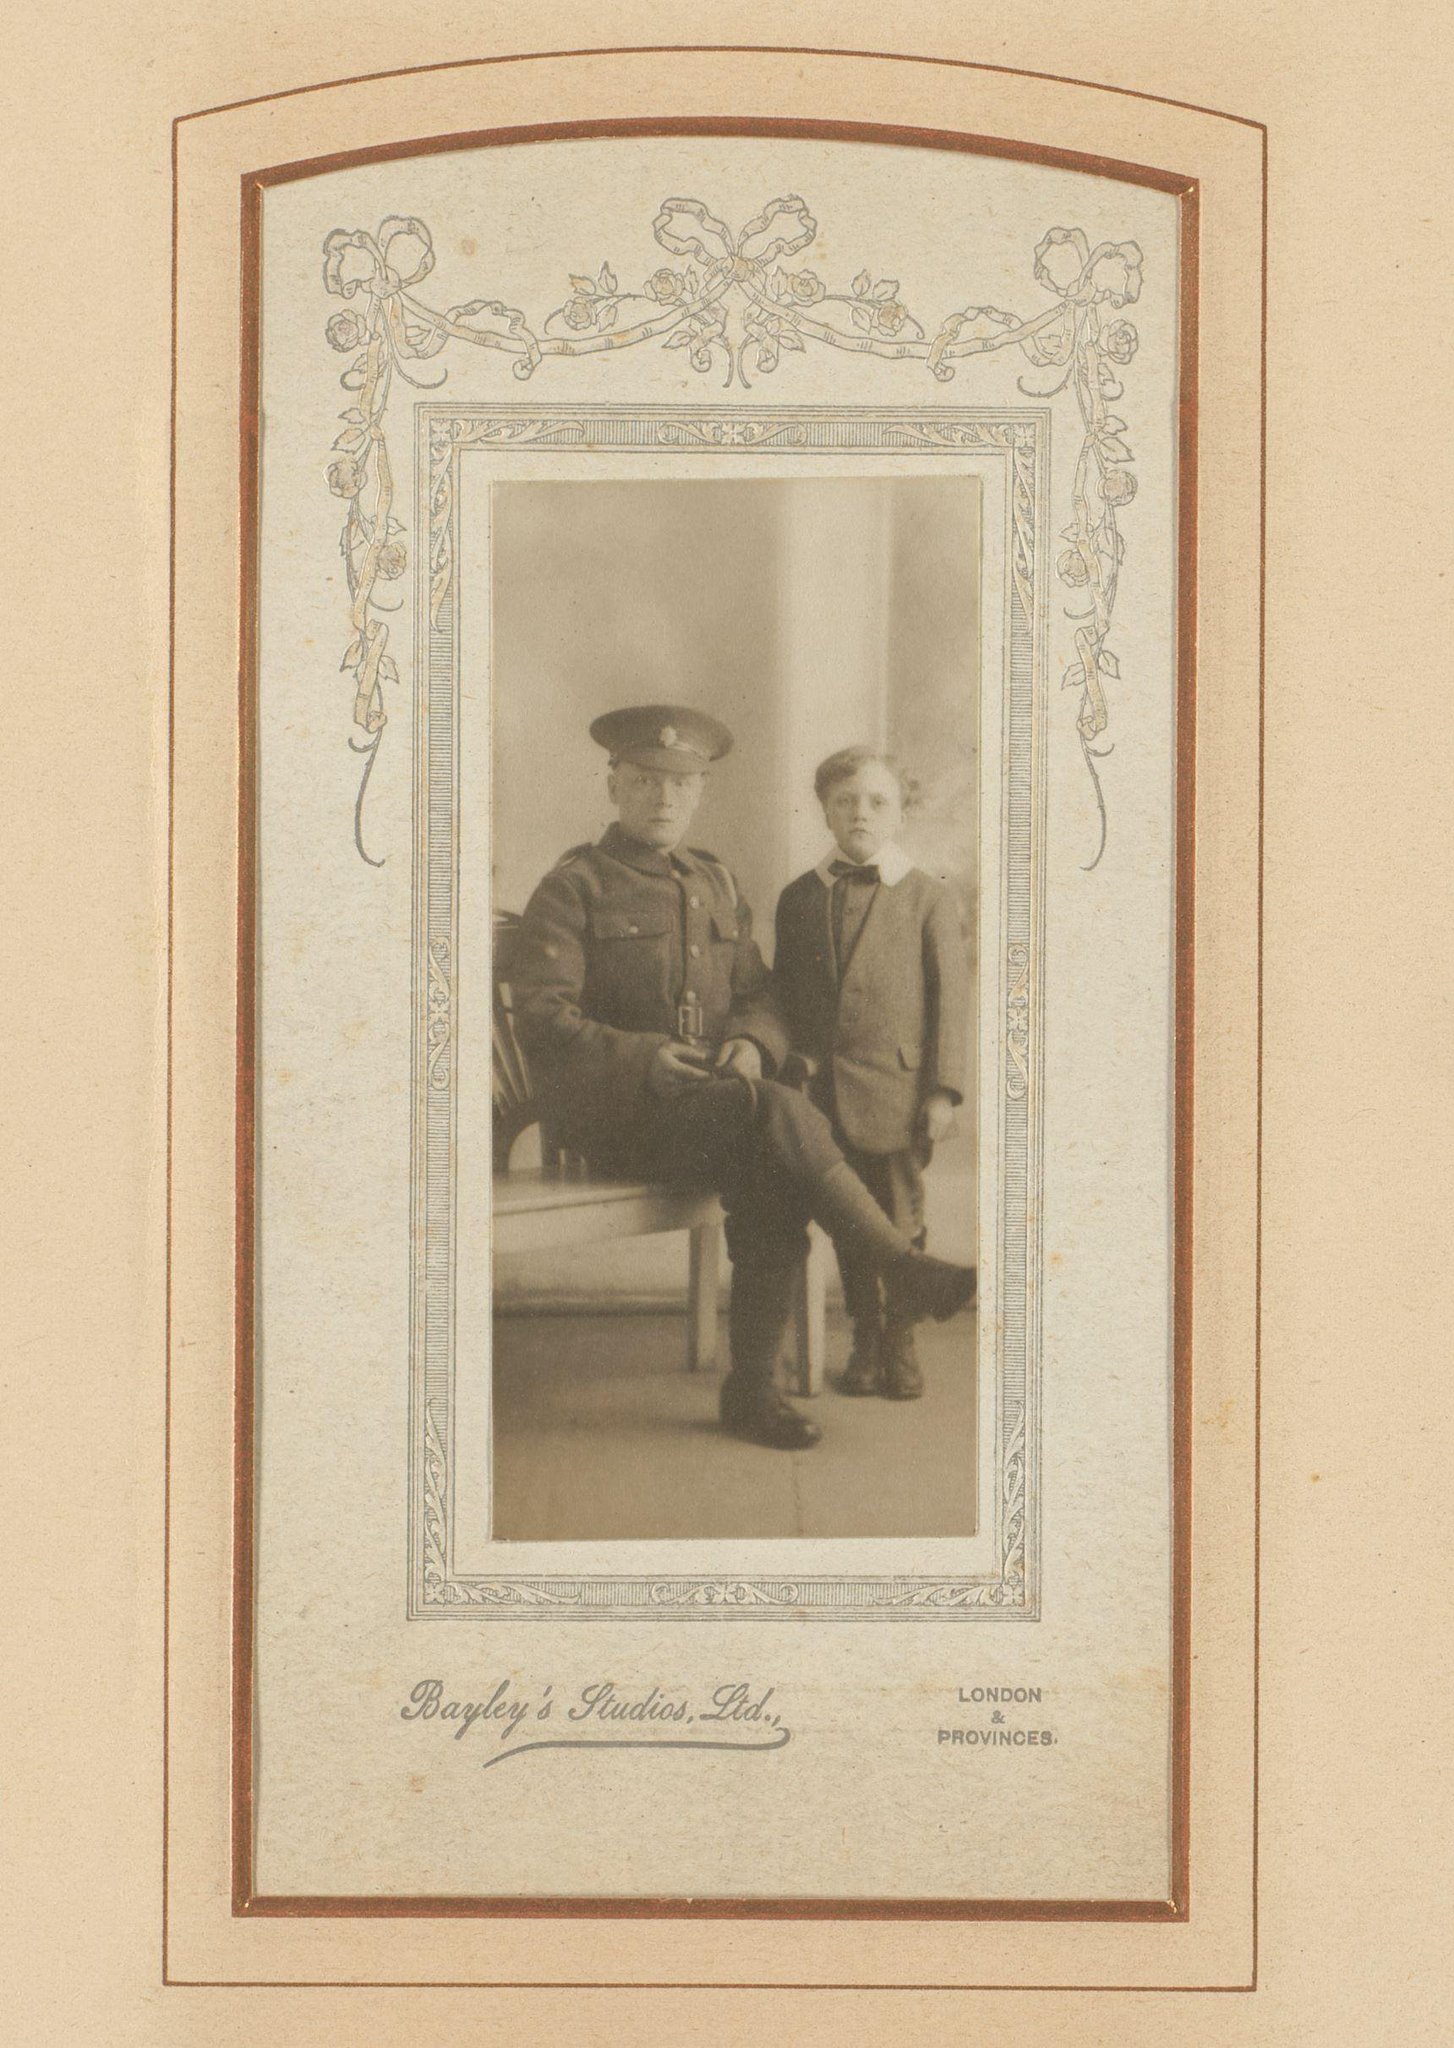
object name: photograph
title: Portret van een man in uniform en jongen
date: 1890-1920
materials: cardboard, photographic support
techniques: gelatin silver print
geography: england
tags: boy (child between toddler and youth), historical persons, (military) uniforms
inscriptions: inscription: ‘Bayley's Studios, Ltd./ London & Provinces’